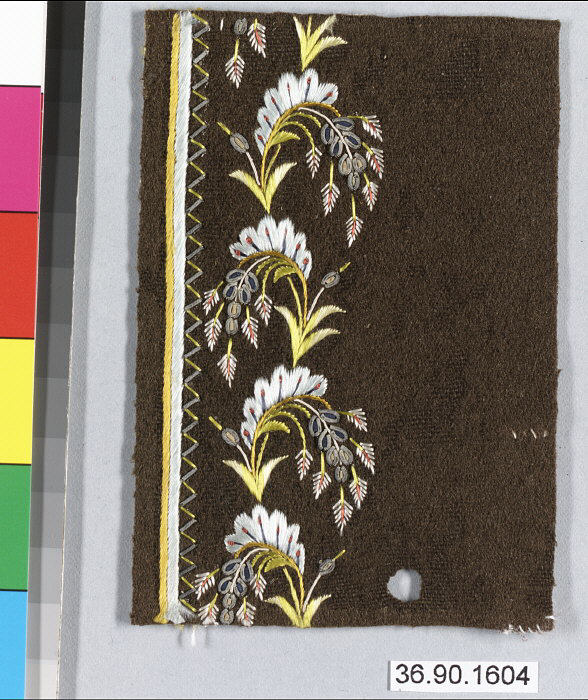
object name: sample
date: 1801-1833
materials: felt, metal thread, silk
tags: flowers